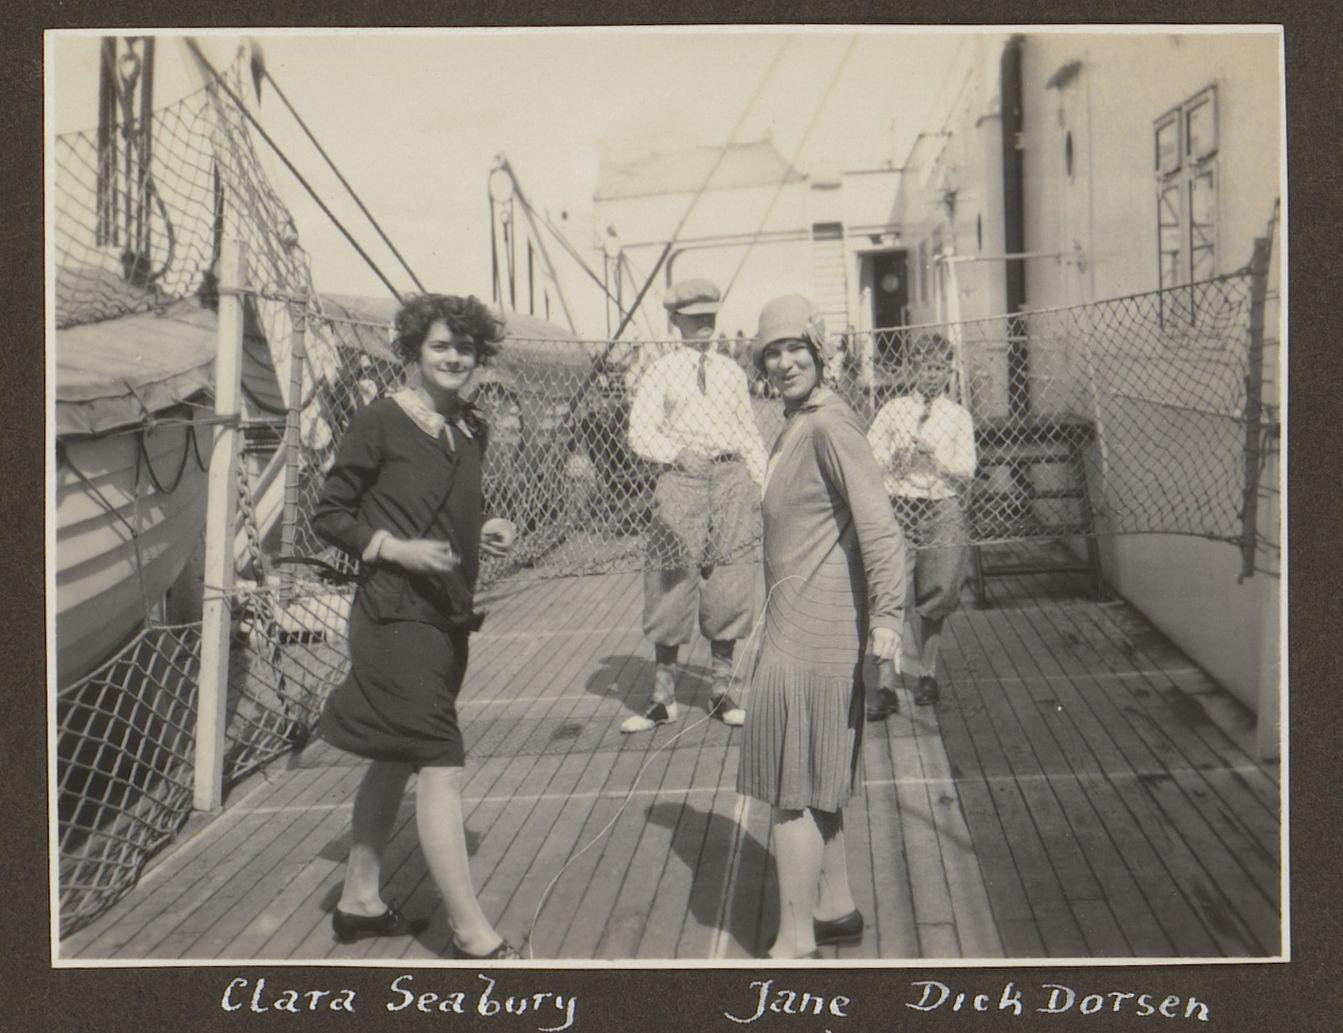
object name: photograph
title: Clara Seaburg, Phil Lilienthal, Jane Herrmann en Dick Dorsen op het dek van een schip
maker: Anonymous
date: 1928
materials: photographic support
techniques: gelatin silver print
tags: adolescent, young woman, maiden, adult woman, historical persons, youth, adolescent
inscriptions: annotation: ‘Clara Seaburg, Jane, Dick Dorsen/ Phil Lilienthal’